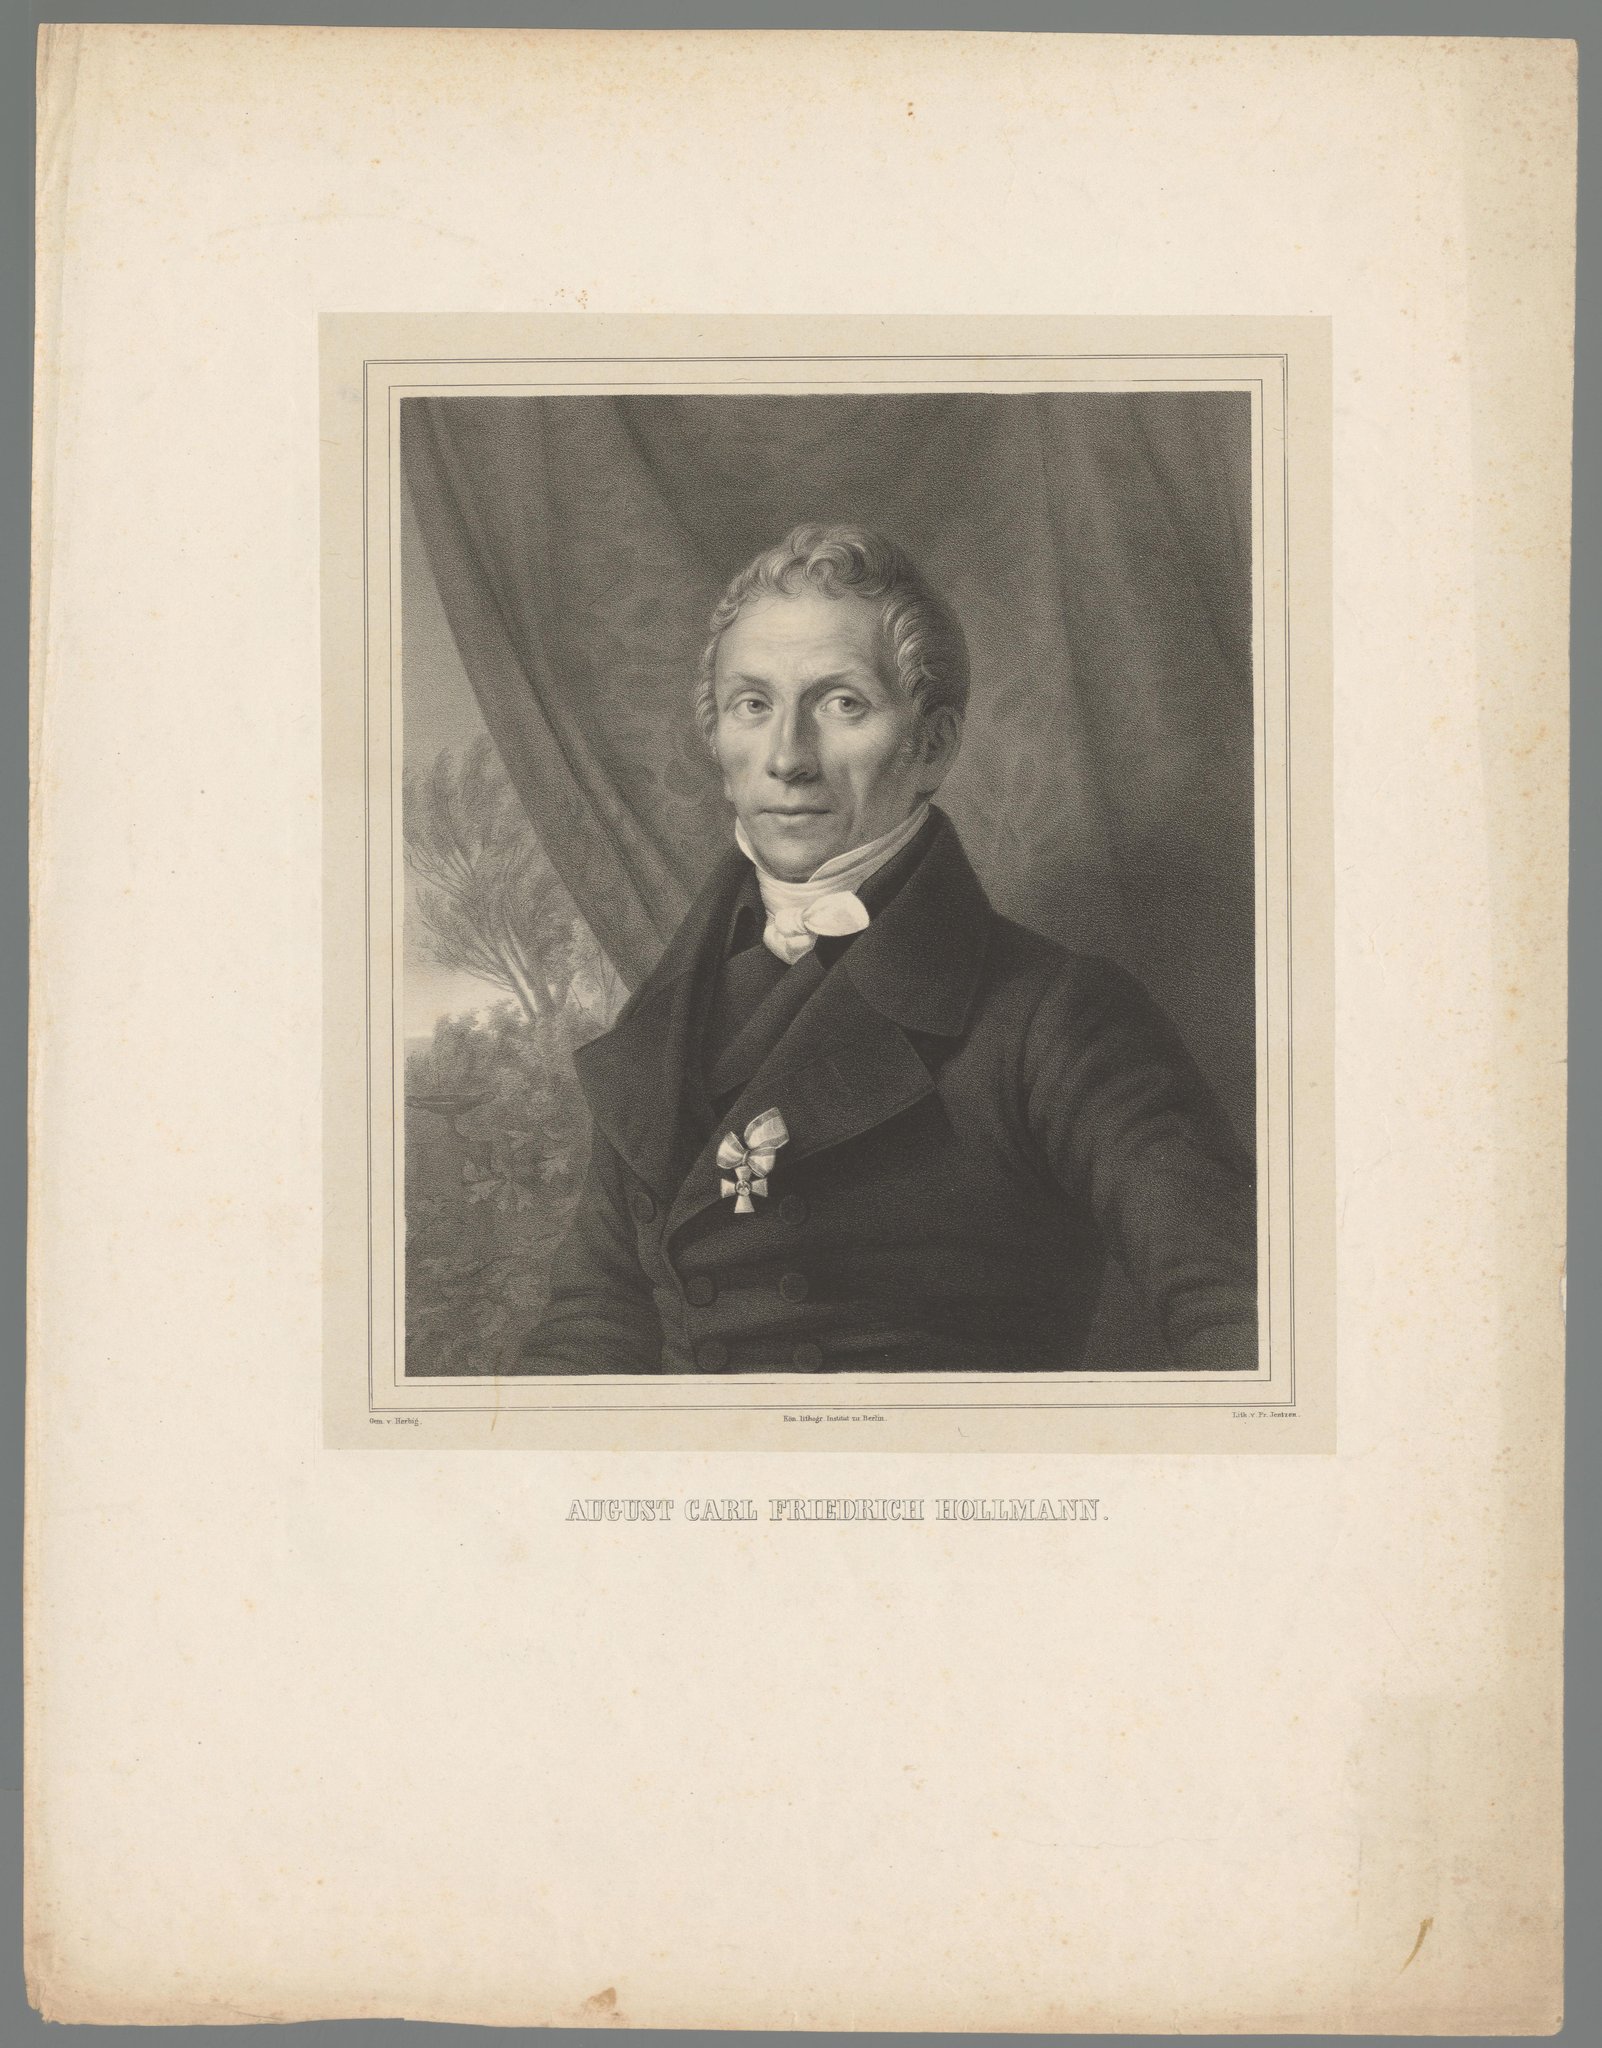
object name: print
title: August Carl Friedrich Hollmann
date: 1814-1875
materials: paper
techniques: lithograph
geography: berlin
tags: adult man, historical persons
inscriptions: collector's mark: Lugt 2228